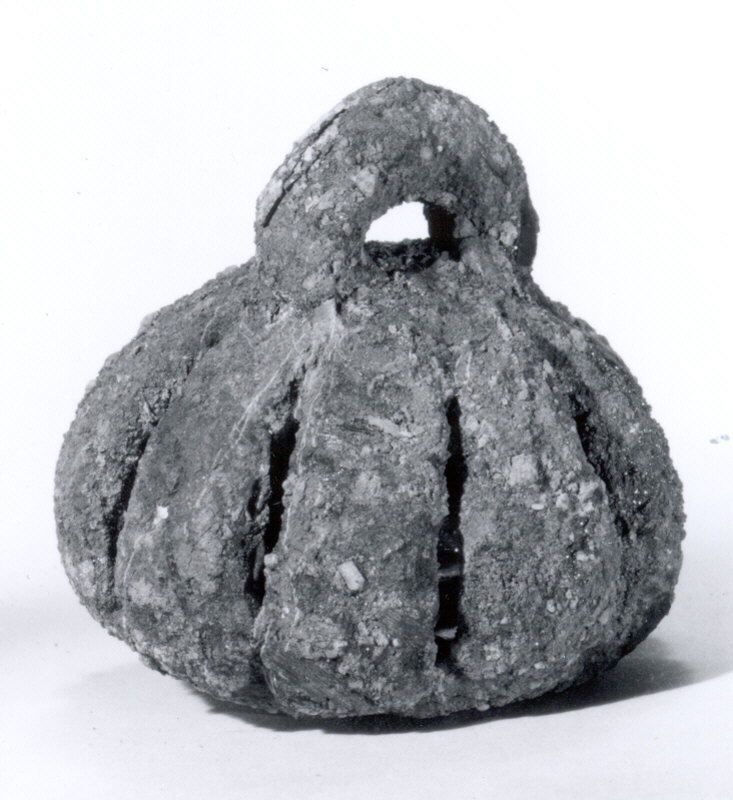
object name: bell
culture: iranian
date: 900-801 BCE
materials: bronze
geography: iran